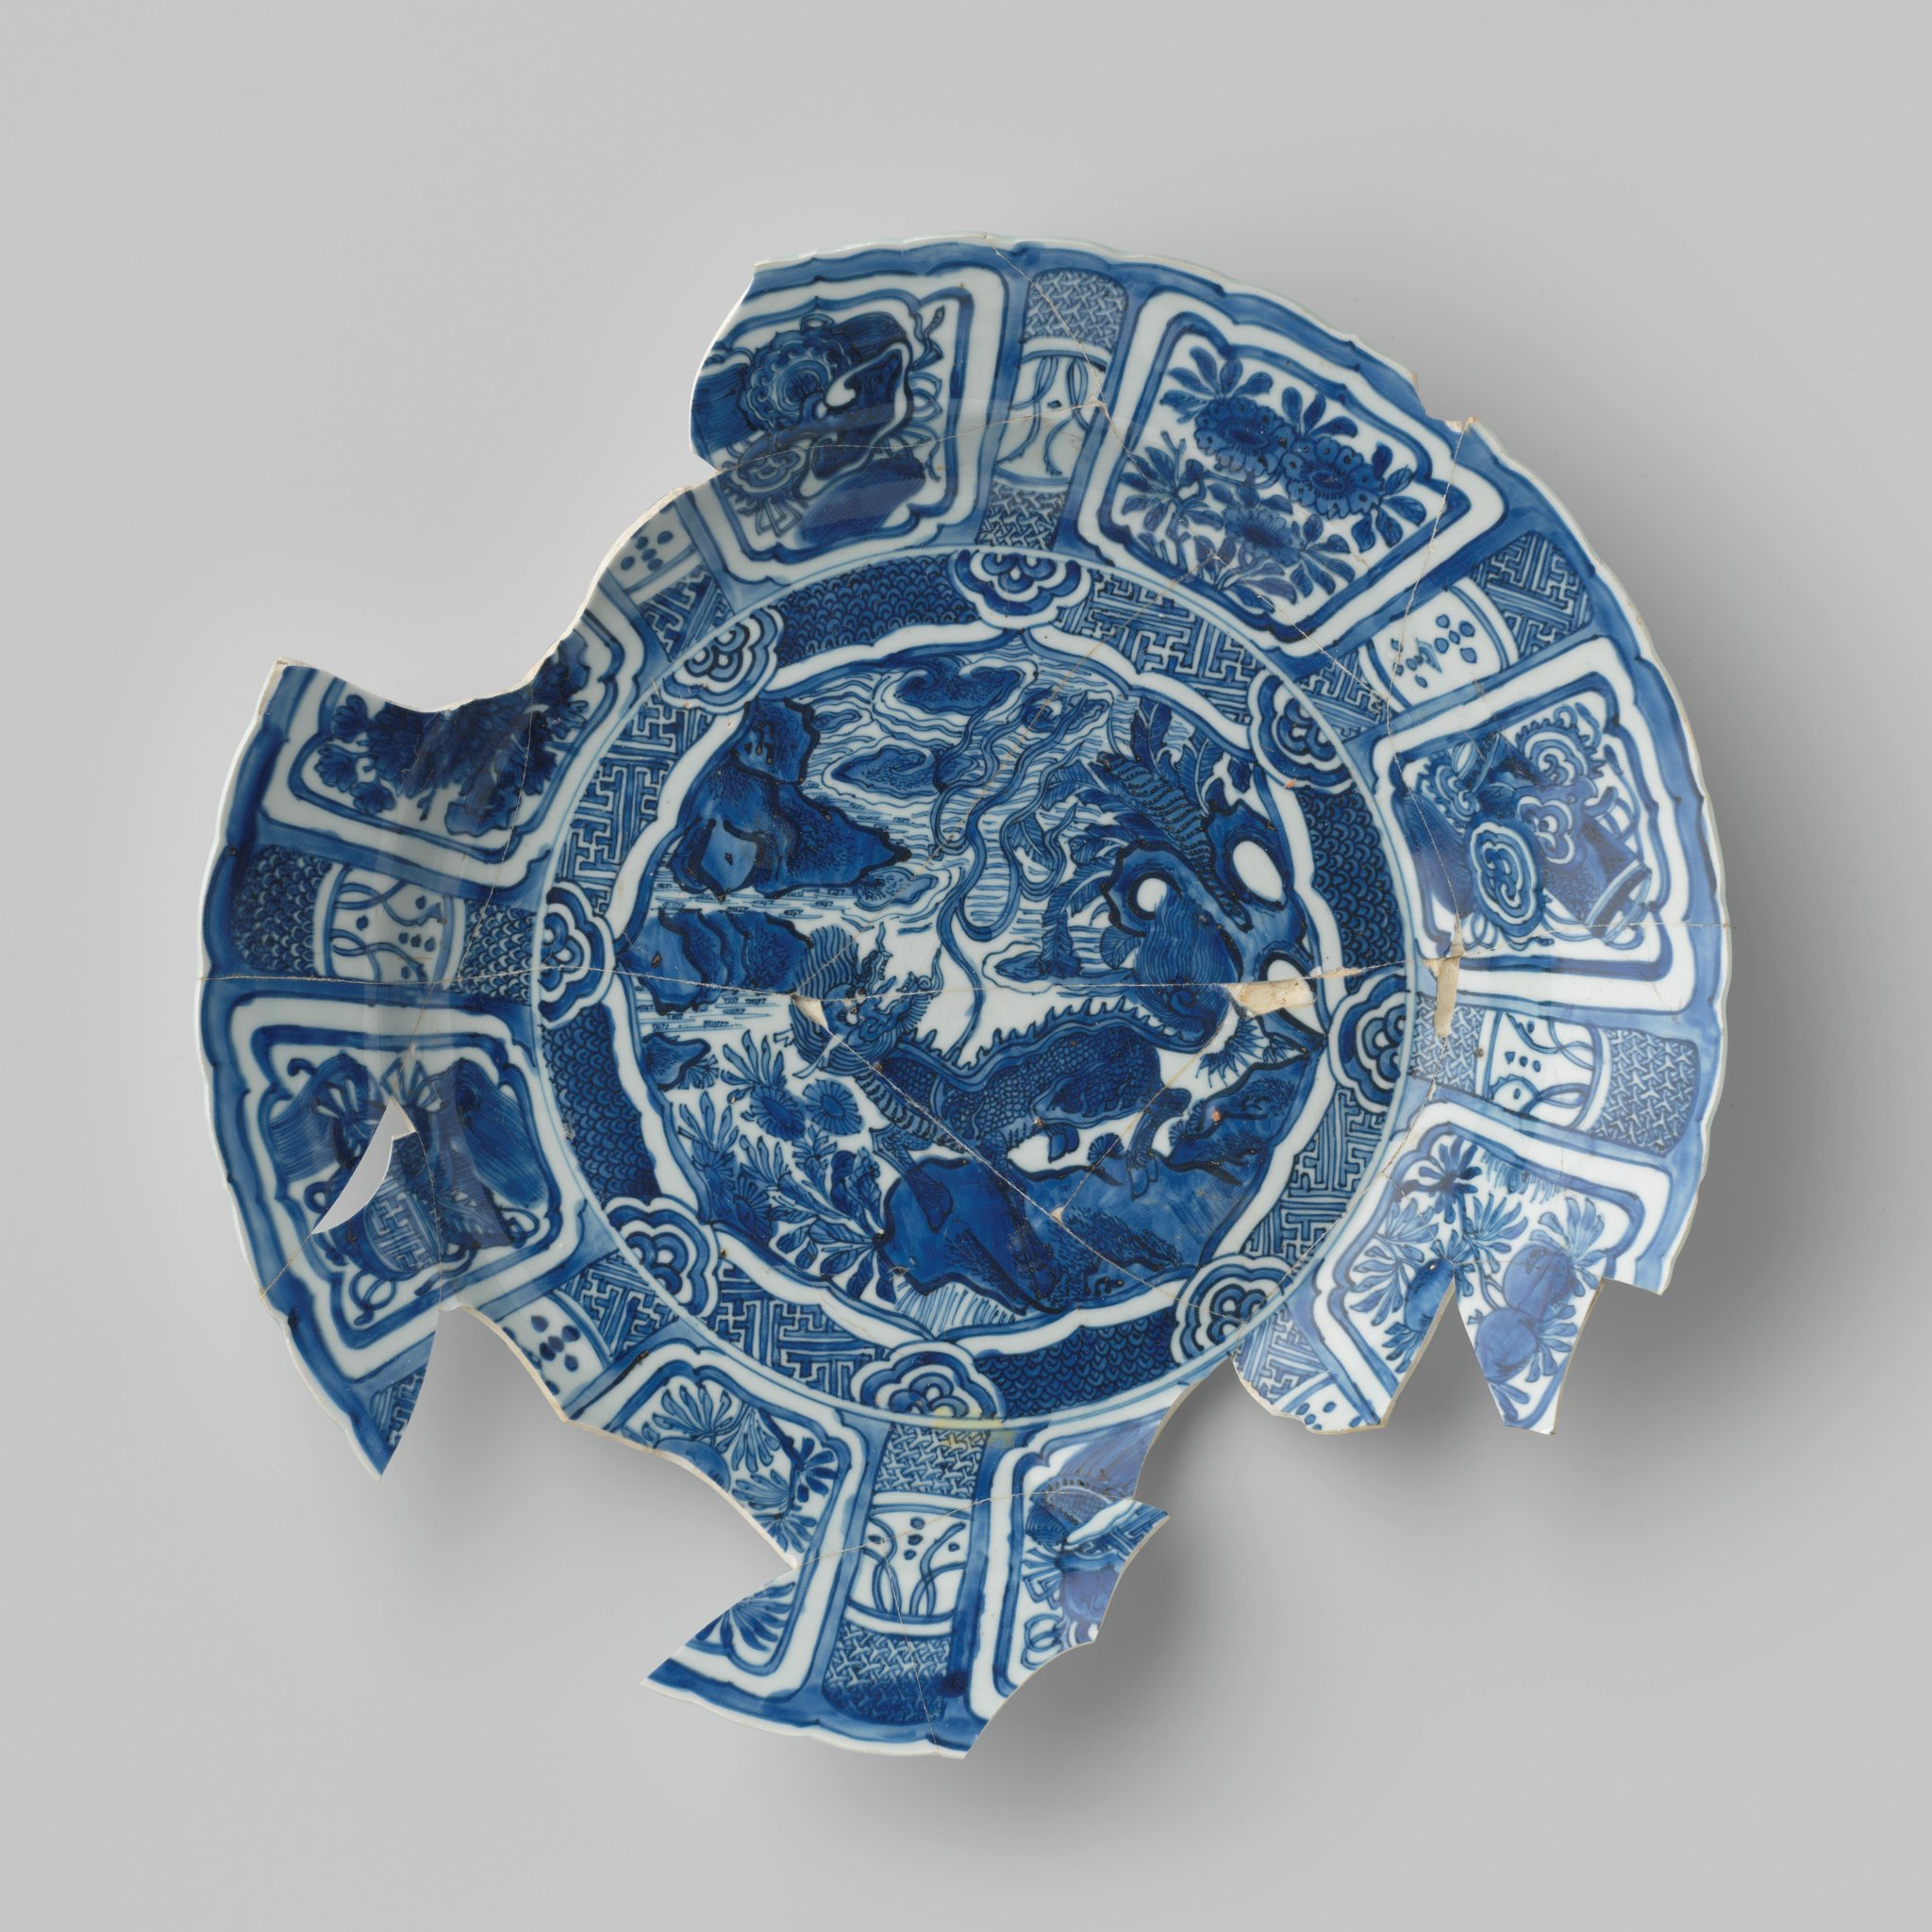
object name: washbowl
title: Schotel uit V.O.C.-schip de 'Witte Leeuw'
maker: Anonymous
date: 1613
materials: bone china, glaze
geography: jingdezhen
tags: verenigde oostindische compagnie, sint-helena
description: Schotel uit V.O.C.-schip de 'Witte Leeuw', 95 % aanwezig; delen van de wand ontbreken. De scherf is glasachtig wit. Het glazuur is blauwgetint en bladdert gedeeltelijk van de liprand af. De bodem is ongeglazuurd. De voetring is gefacetteerd en staat naar binnen. Er zijn meer dan 20 korrels ovenzand aangetroffen. De lip is geschulpt. Lampetschotel.